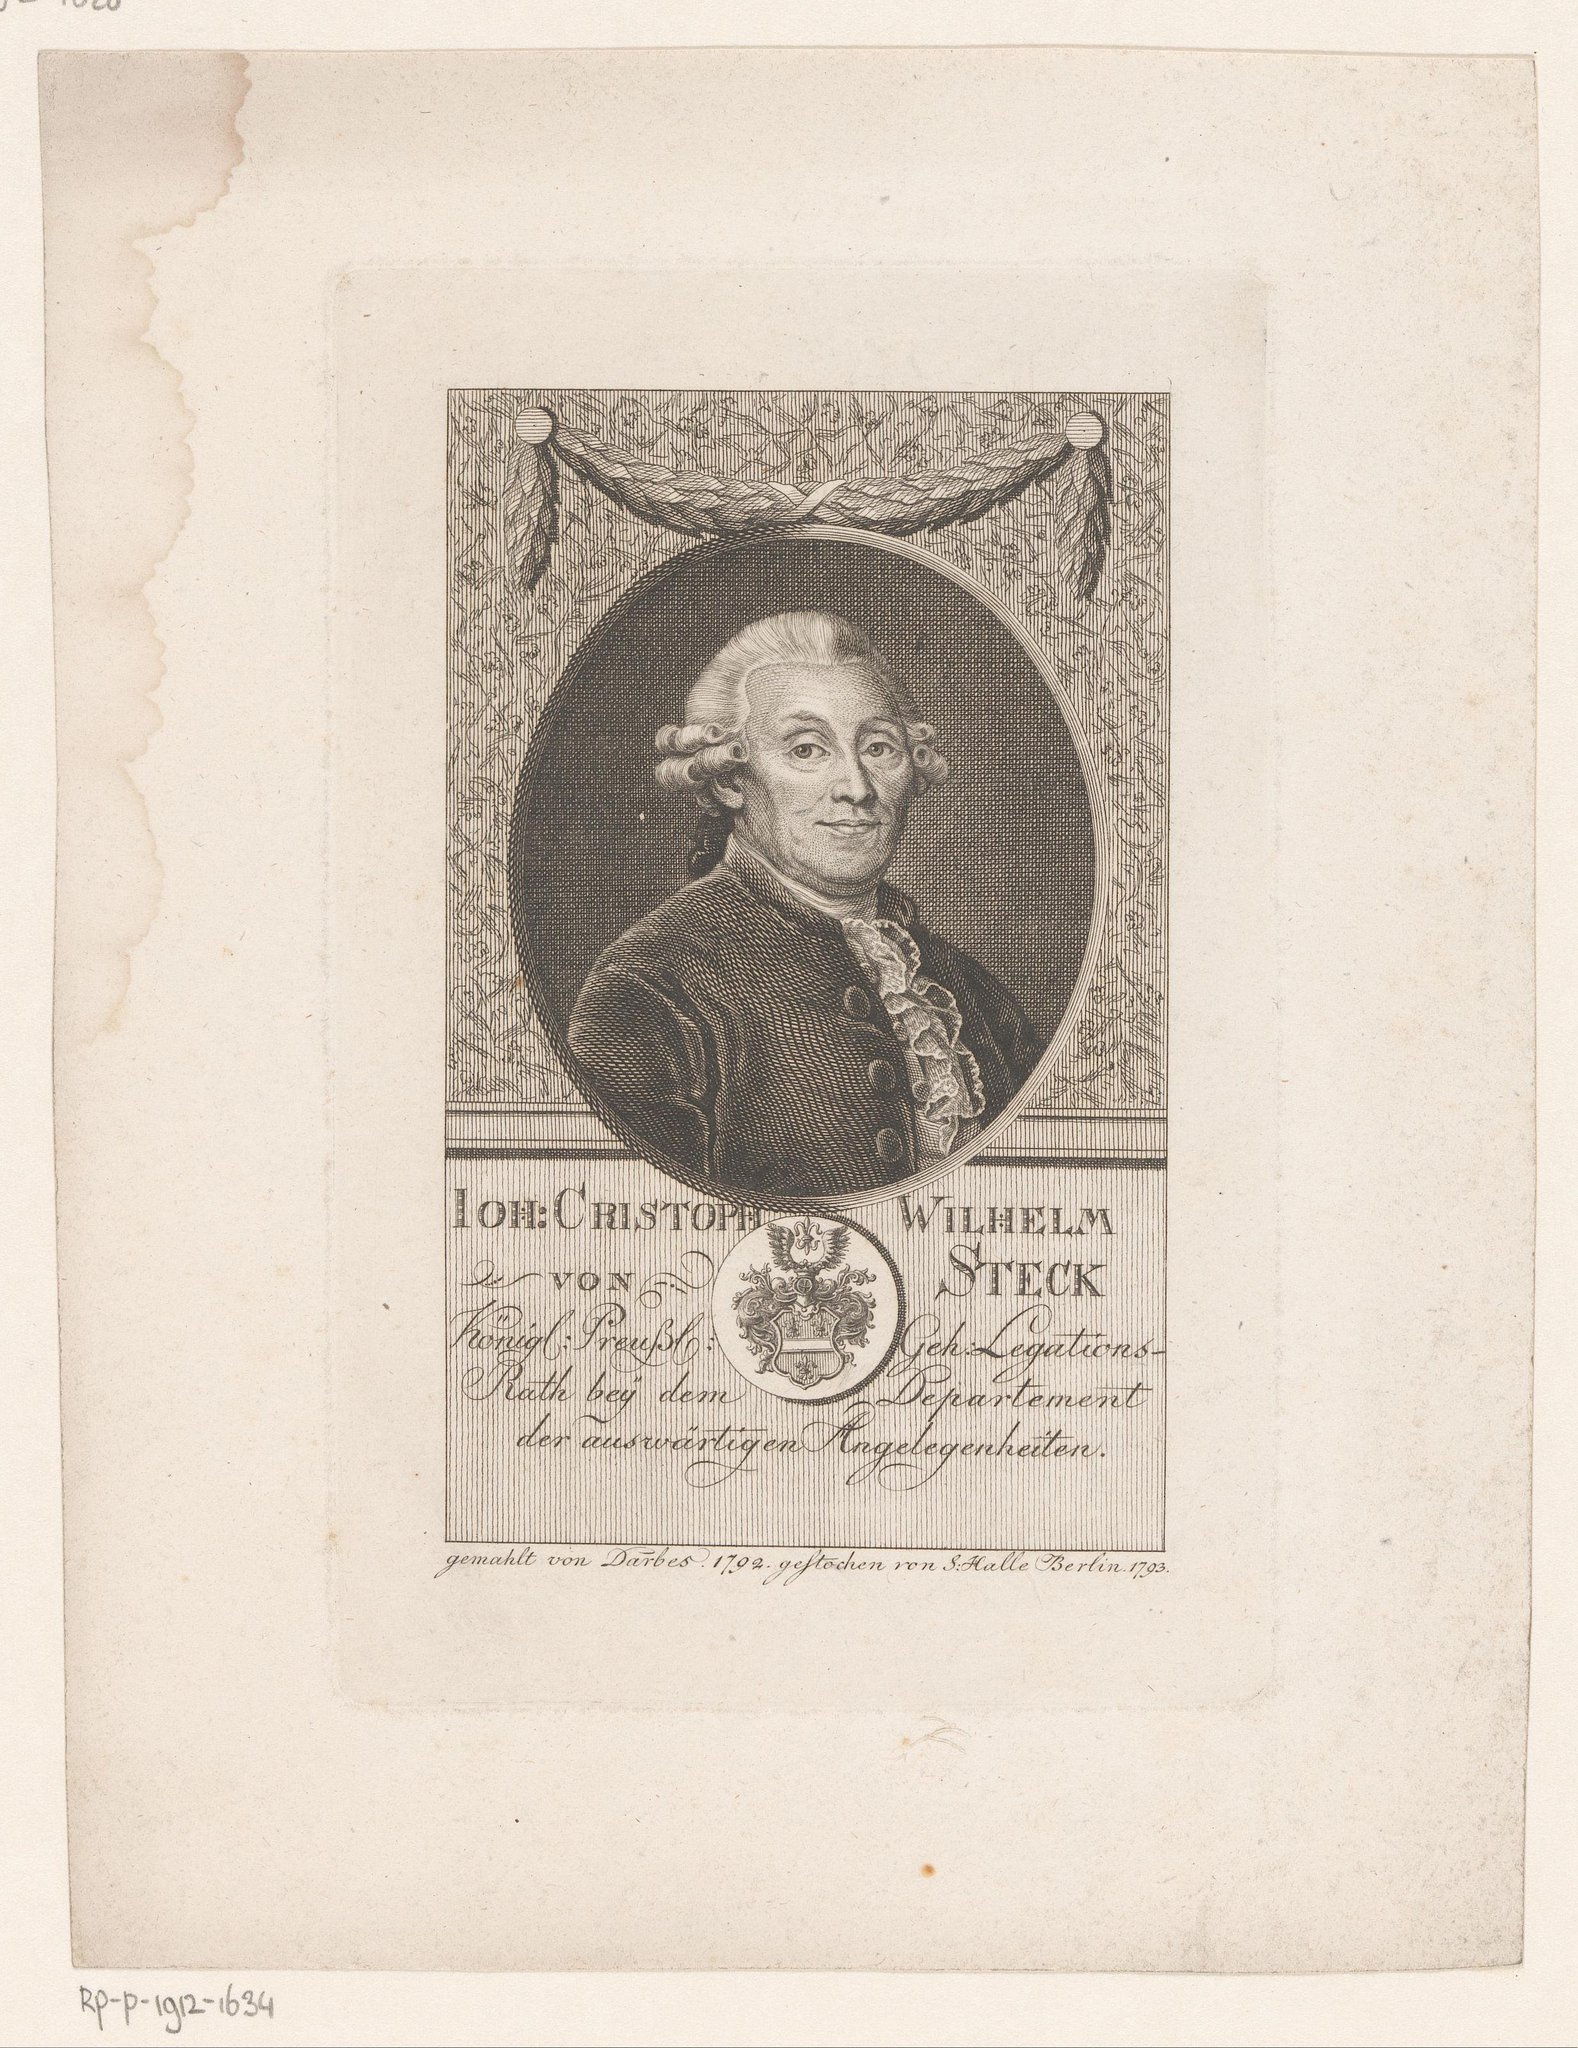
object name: print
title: Portret van Johann Christoph Wilhelm von Steck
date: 1793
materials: paper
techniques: engraving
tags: historical persons, ornament ~ festoon, garland, armorial bearing, heraldry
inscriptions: collector's mark: Lugt 2228